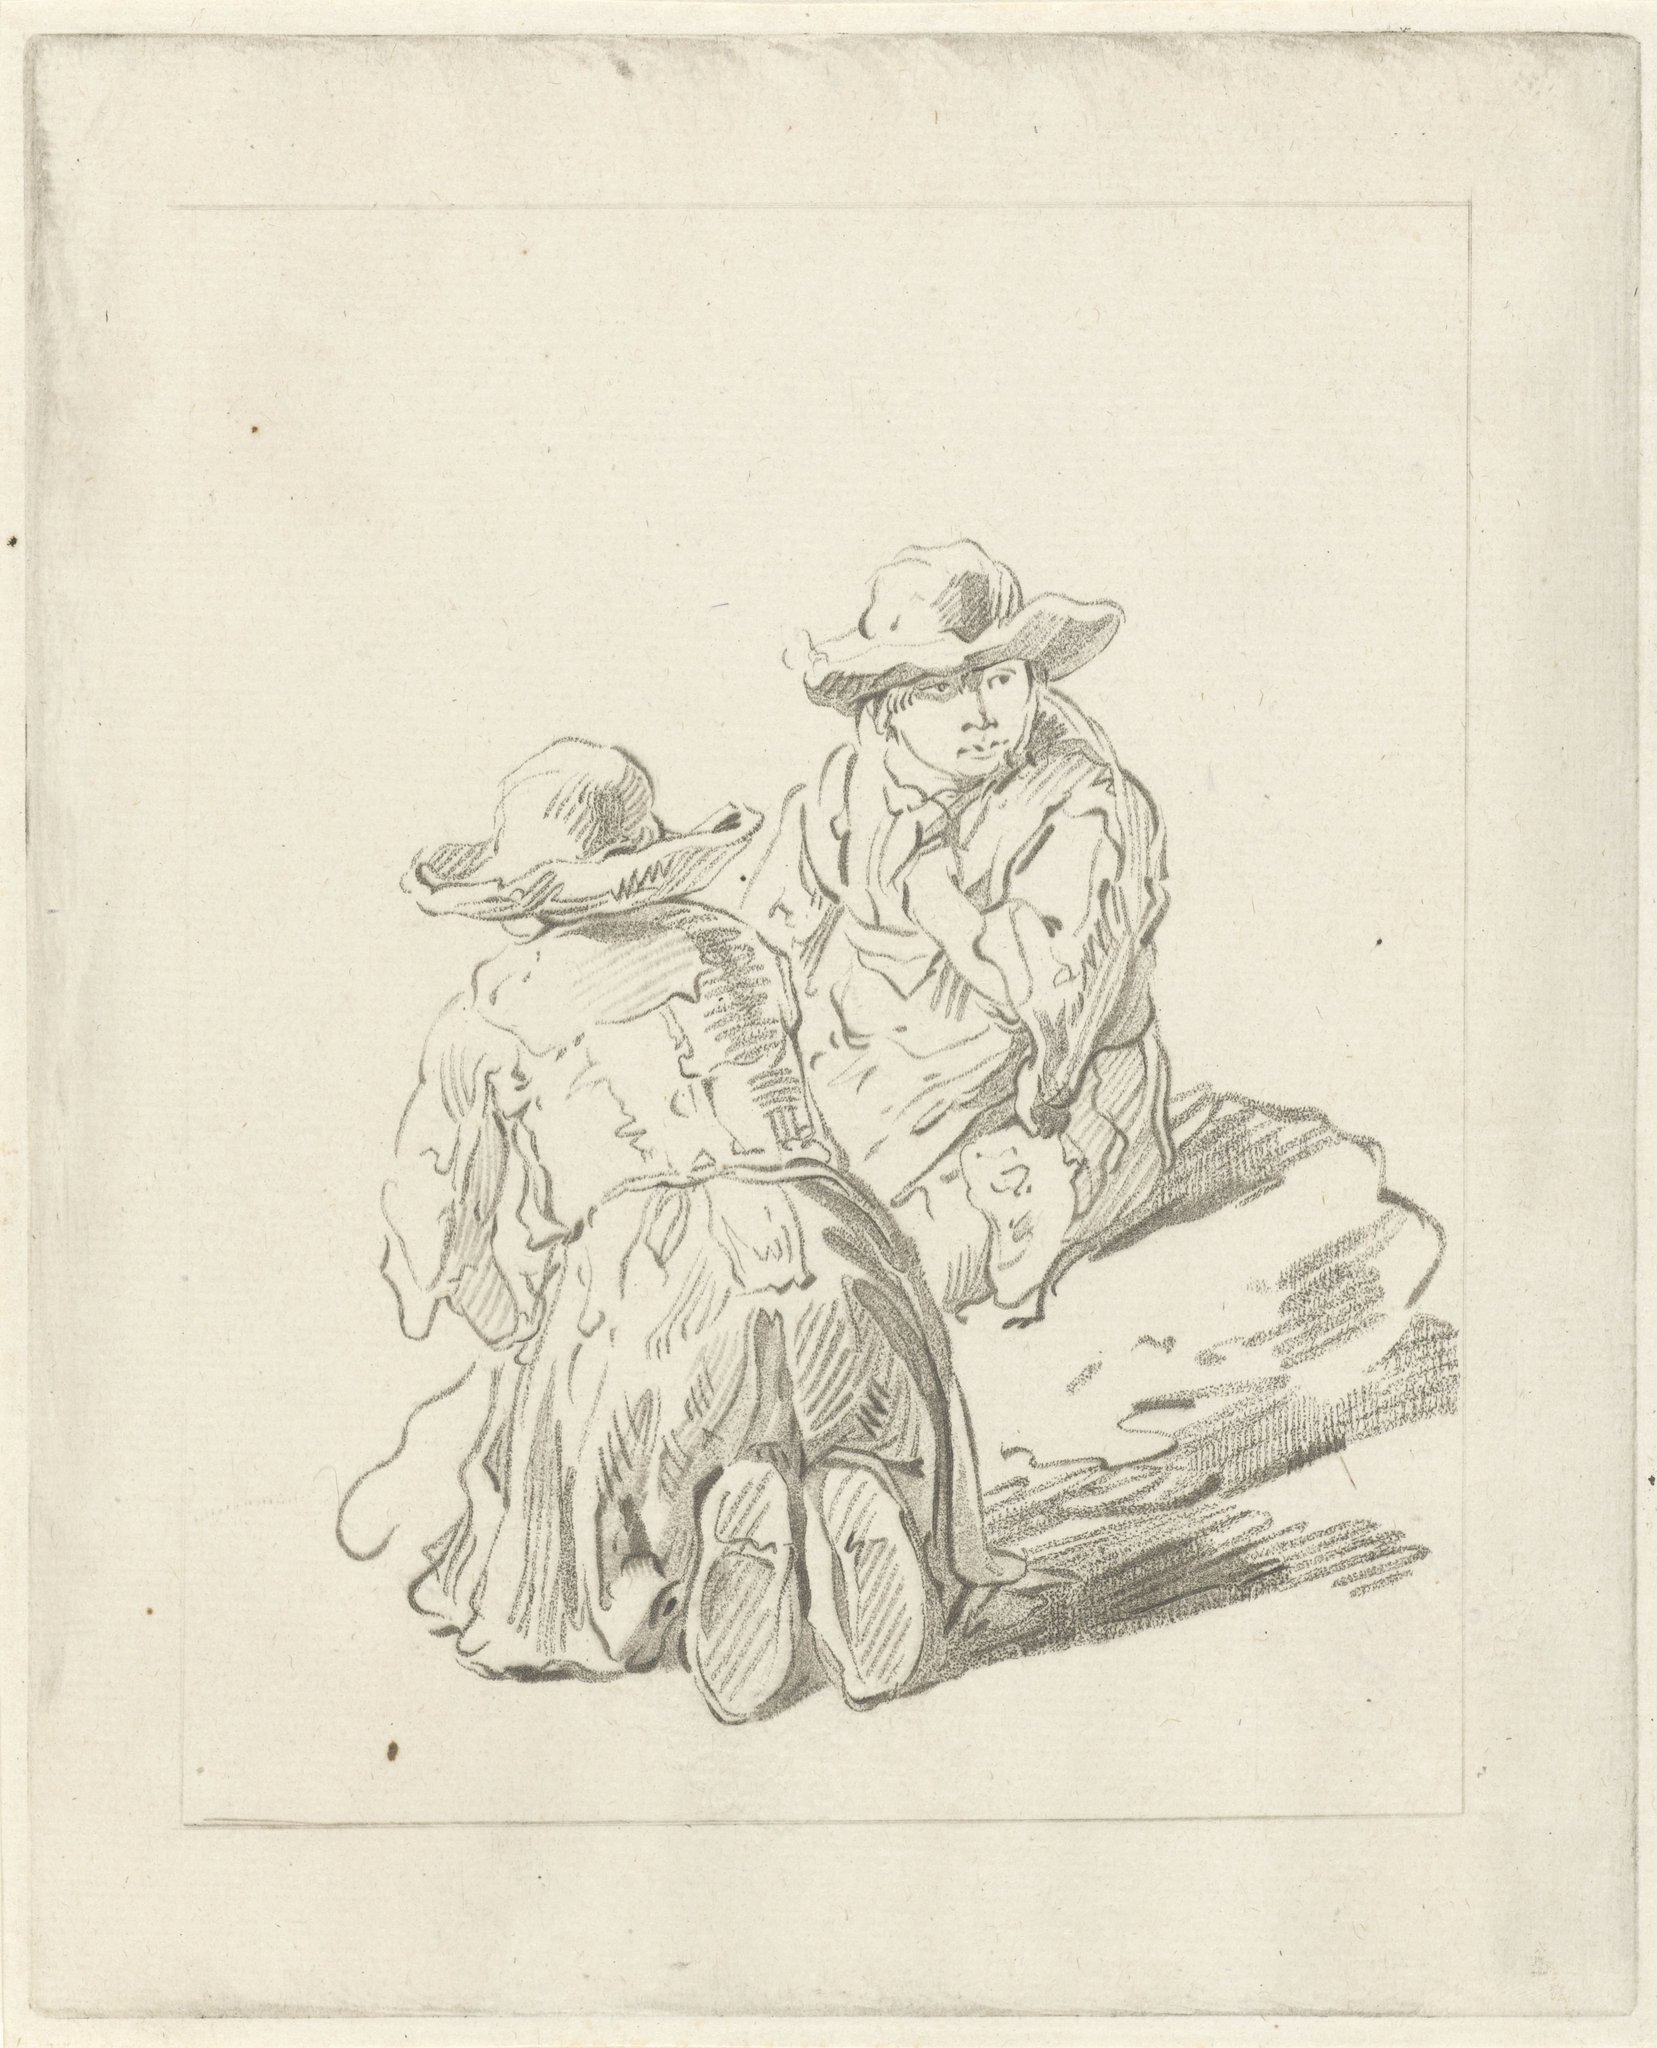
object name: print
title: Twee op de grond zittende jongens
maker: bernhard schreuder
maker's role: print maker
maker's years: -1780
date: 1767-1780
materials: paper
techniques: printmaking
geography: netherlands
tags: boy (child between toddler and youth), head-gear: hat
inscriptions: collector's mark: Lugt 240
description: Twee op de grond zittende jongens. De een zittend op de knieën en op de rug gezien, de ander zittend op een verhoging.